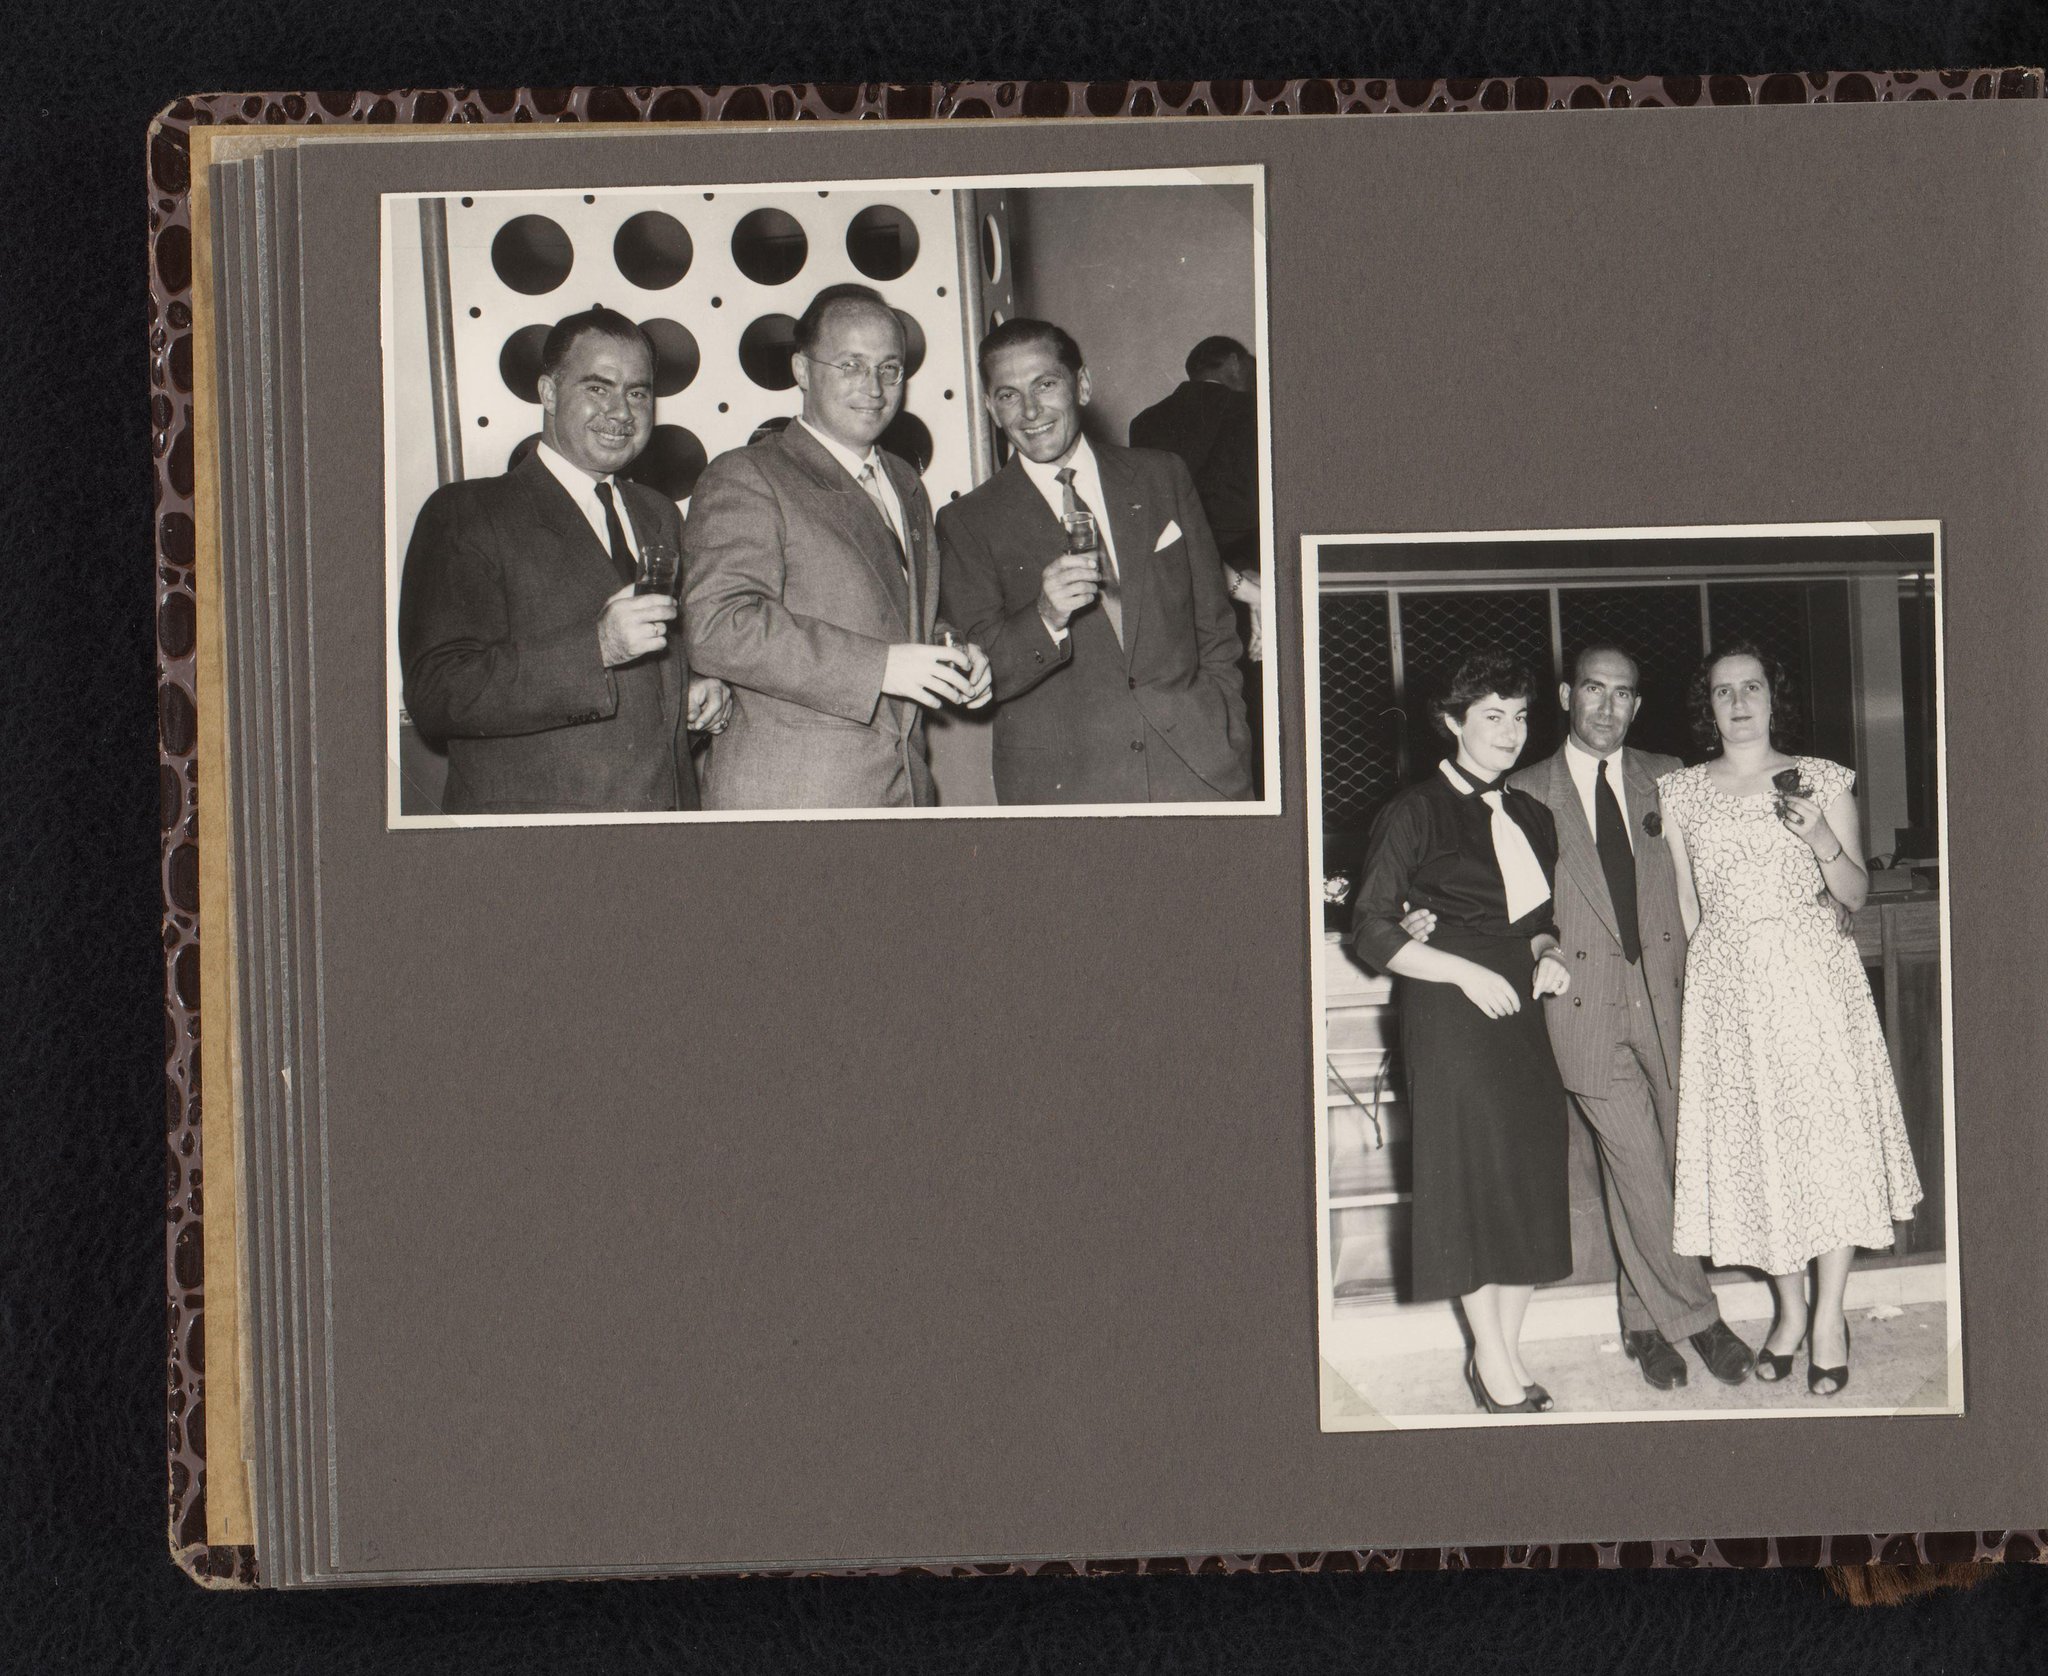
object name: album leaf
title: Onbekende collega's van Isabel Wachenheimer tijdens haar periode bij KLM tijdens een feestje en Isabel Wachenheimer met haar derde echtgenoot Gideon Elon, 1947-1955, Israël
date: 1947-1955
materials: cardboard, photographic support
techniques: gelatin silver print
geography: israel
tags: leiden, isabel wachenheimer-elon, gideon elon, historical persons - bb - woman, historical persons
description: Blad bevat twee foto's van Isabel Wachenheimer (in bewerkte jurk), Gideon Elon (lachend, met pochet) en onbekende collega's. Uit album half formaat, kunstlederen omslag met koordbinding.